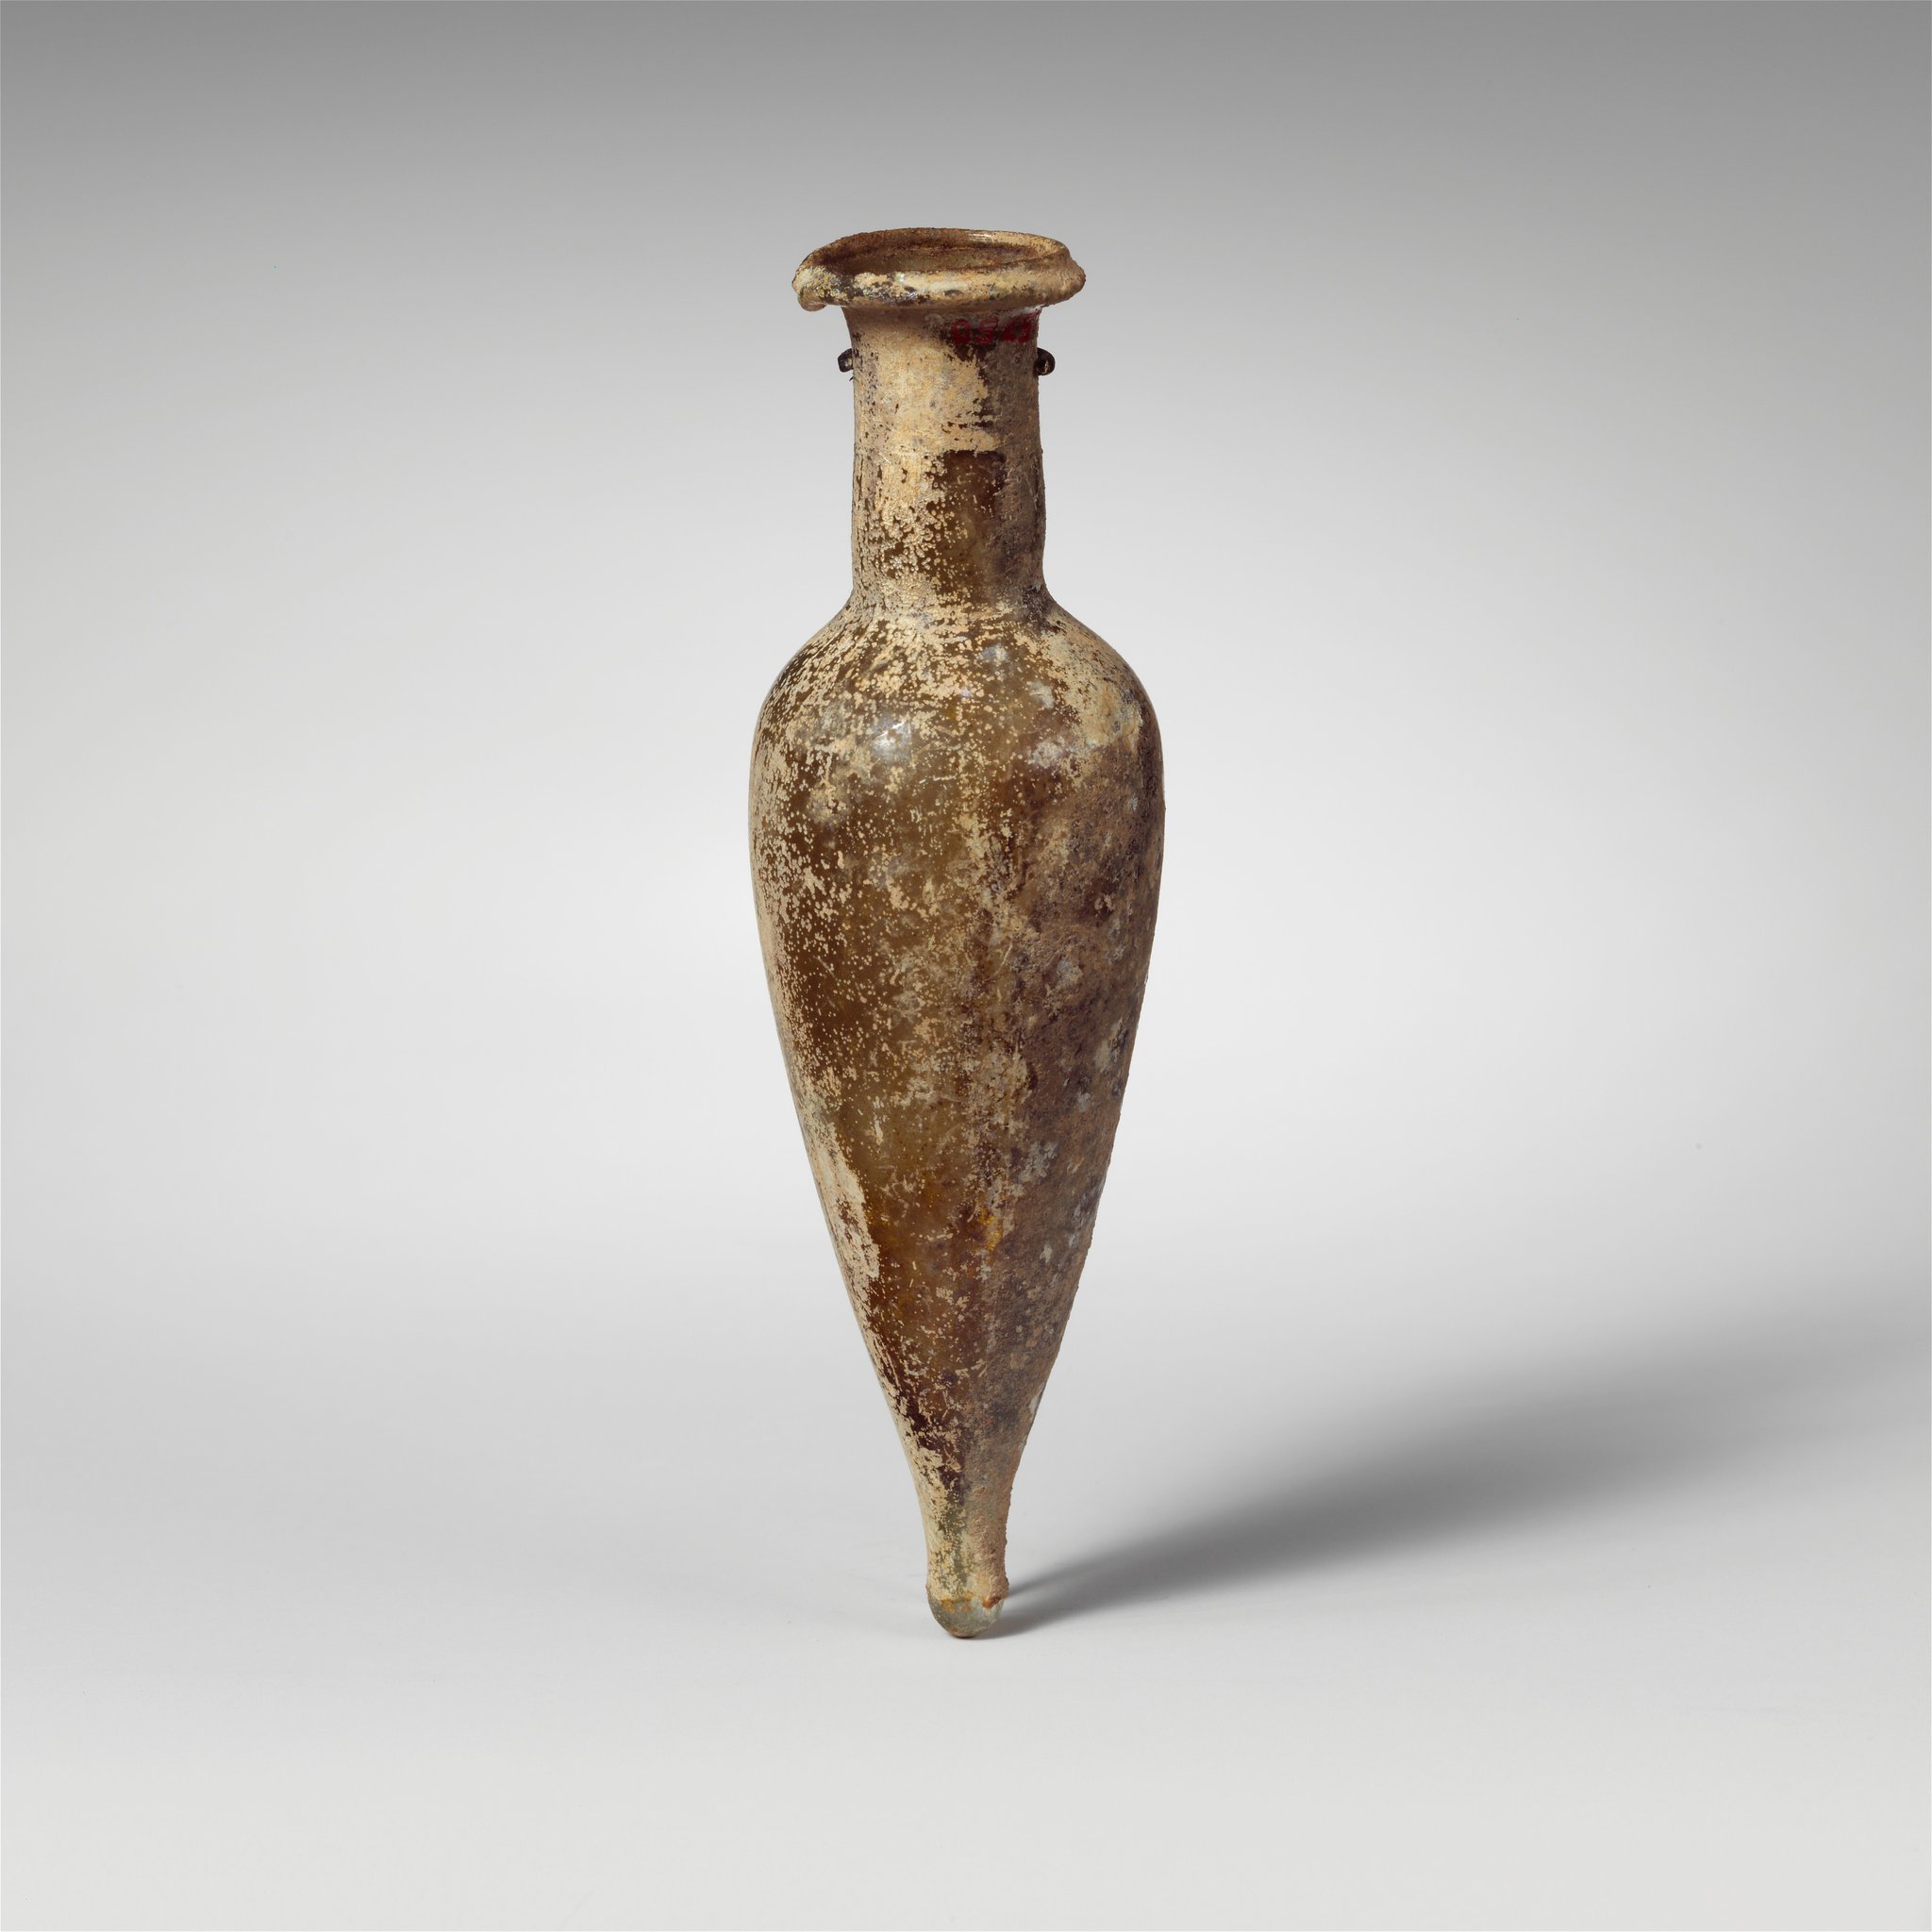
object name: bottle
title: Glass perfume bottle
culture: roman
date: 1-100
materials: glass